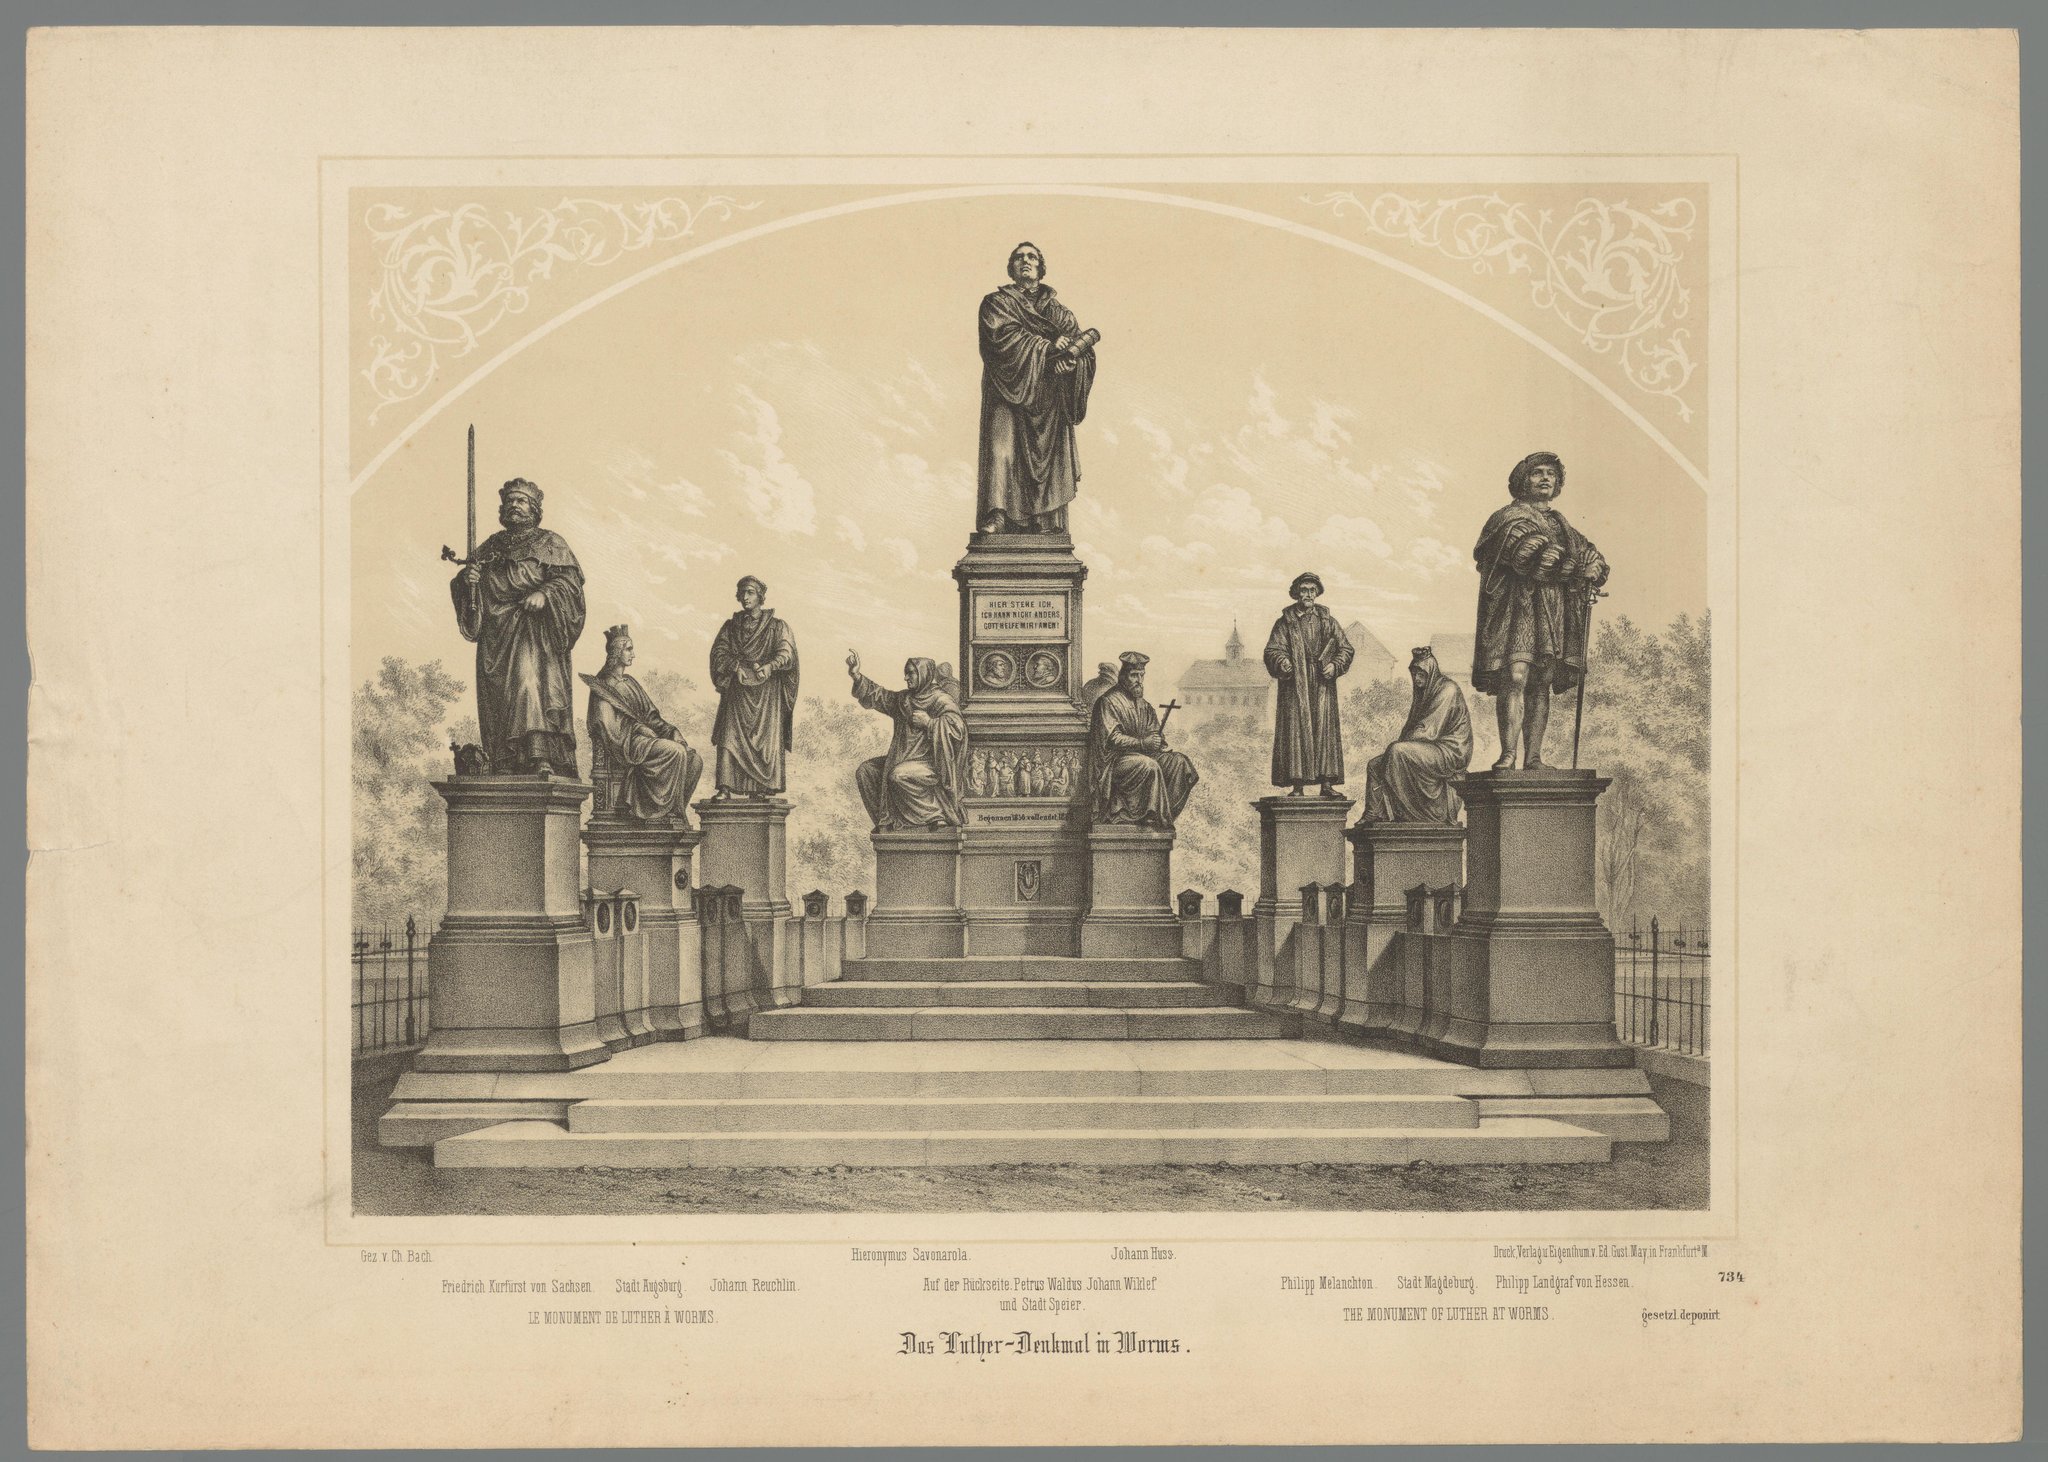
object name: print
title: Das Luther-Denkmal in Worms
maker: eduard gustav may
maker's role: printer, publisher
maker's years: 1818-1907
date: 1868-1899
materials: paper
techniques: tone lithography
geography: frankfurt am main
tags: priest, martin luther, monument, statue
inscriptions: : ‘Gesetz.deponirt’, collector's mark: Lugt 2228